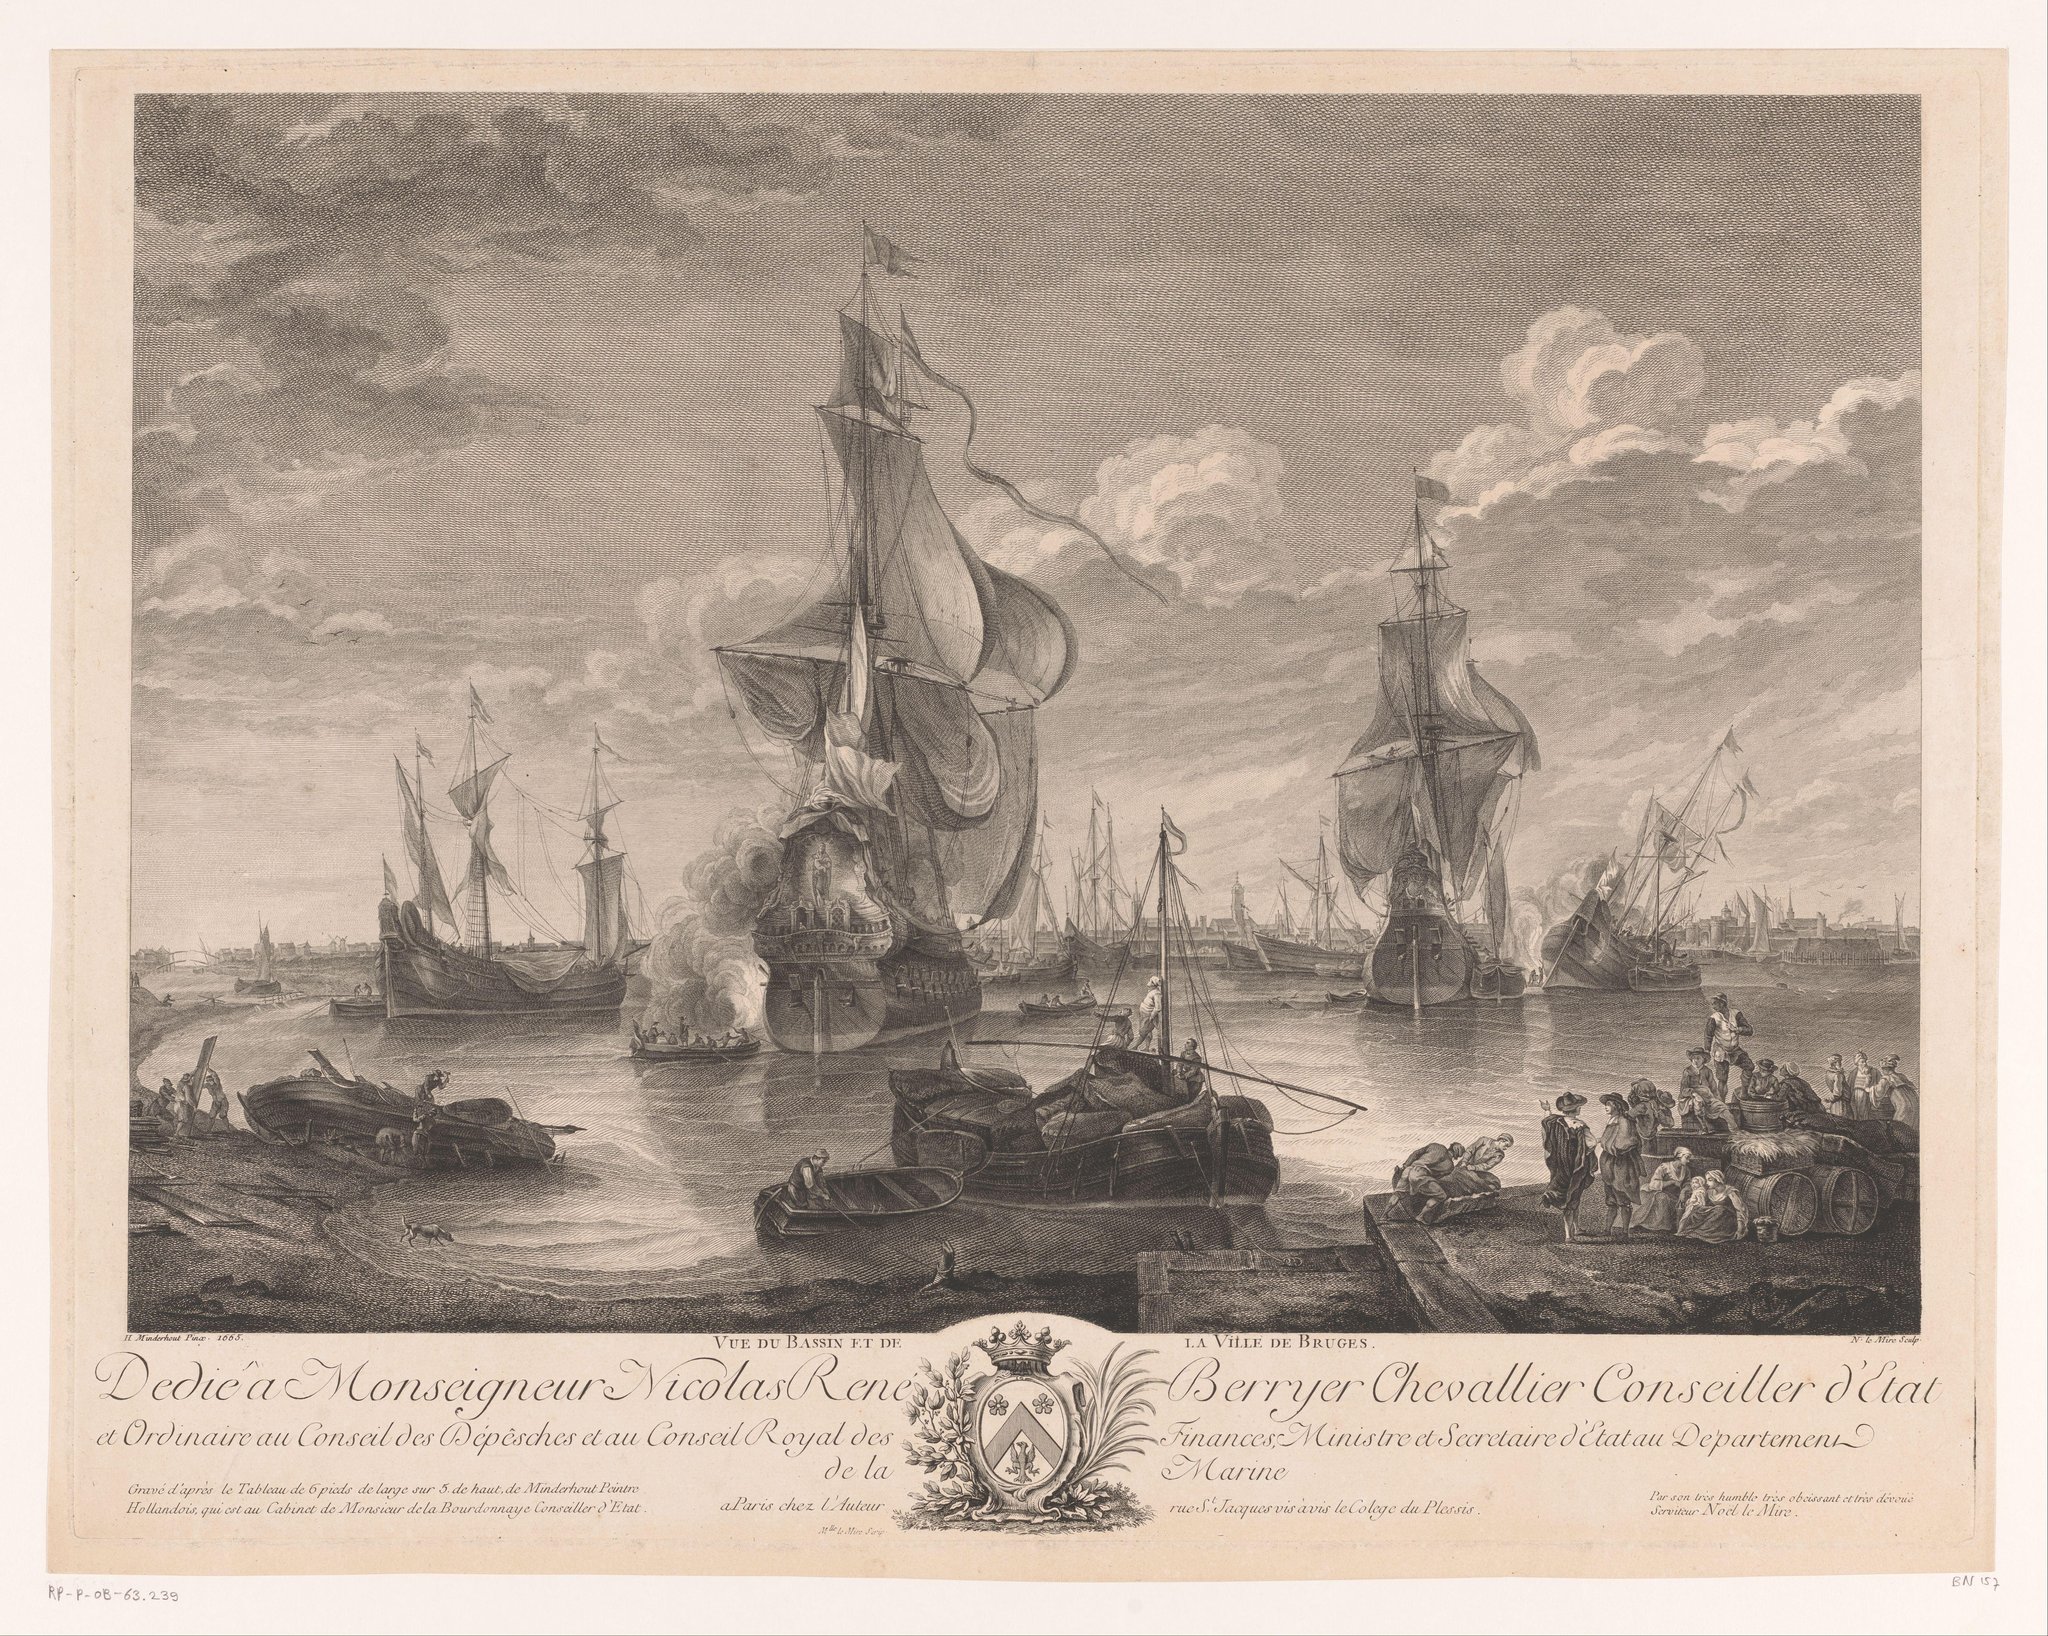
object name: print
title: Gezicht op de haven van Brugge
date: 1759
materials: paper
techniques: engraving, etching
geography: france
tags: harbour, ships (in general), bruges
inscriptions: watermark